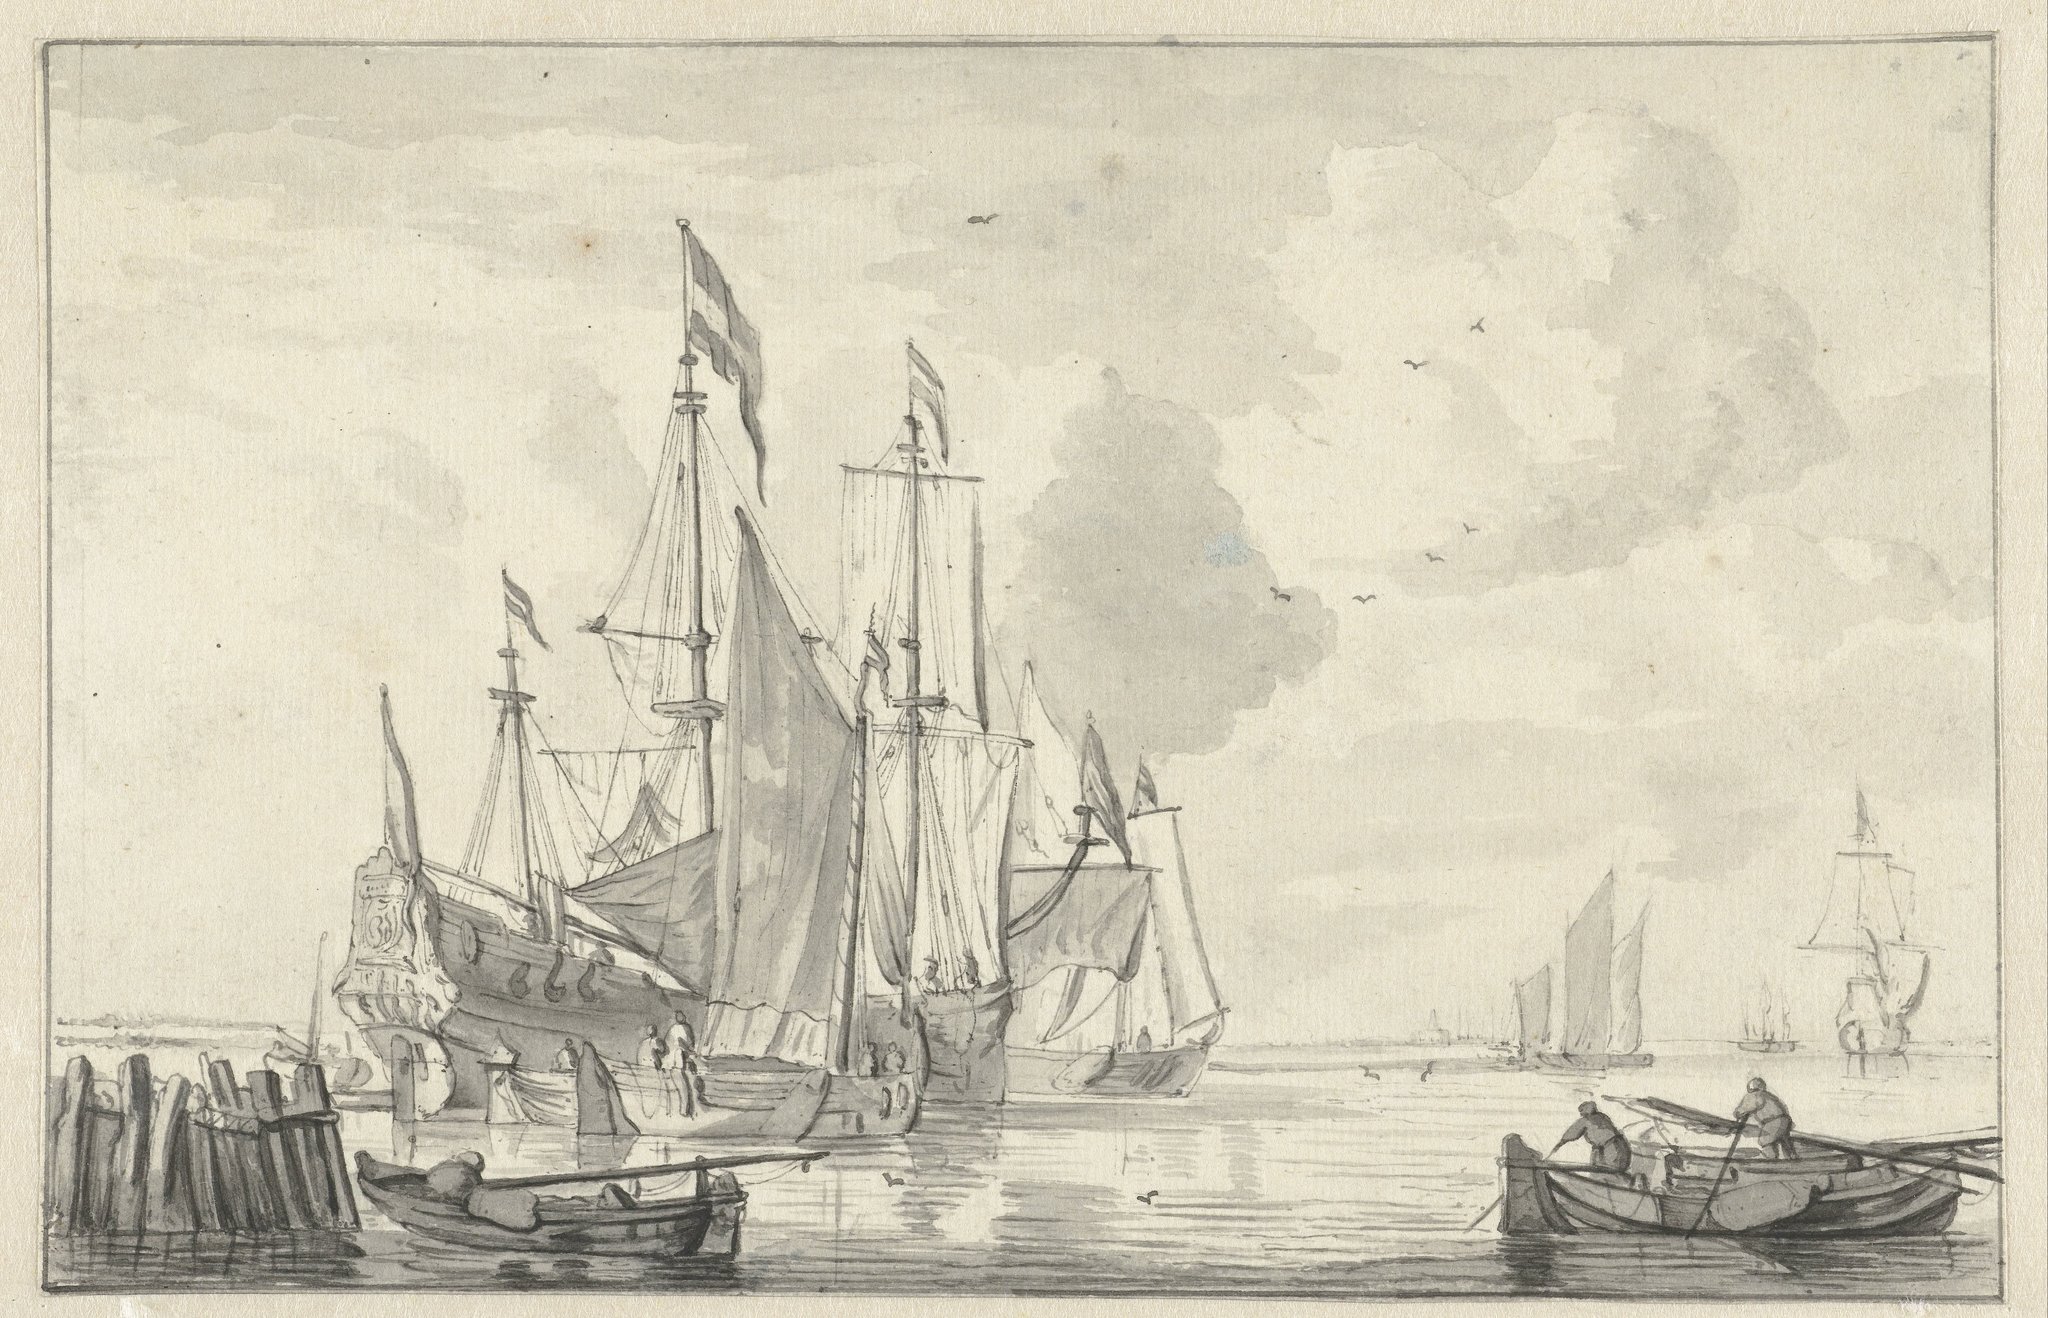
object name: drawing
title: Zeegezicht met enkele schepen in kalm water bij de kust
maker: willem van de velde (ii)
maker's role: draughtsman, painter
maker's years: 1633-1707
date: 1643-1707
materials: ink, paper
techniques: brush, pen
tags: sailing-ship, sailing-boat, coast